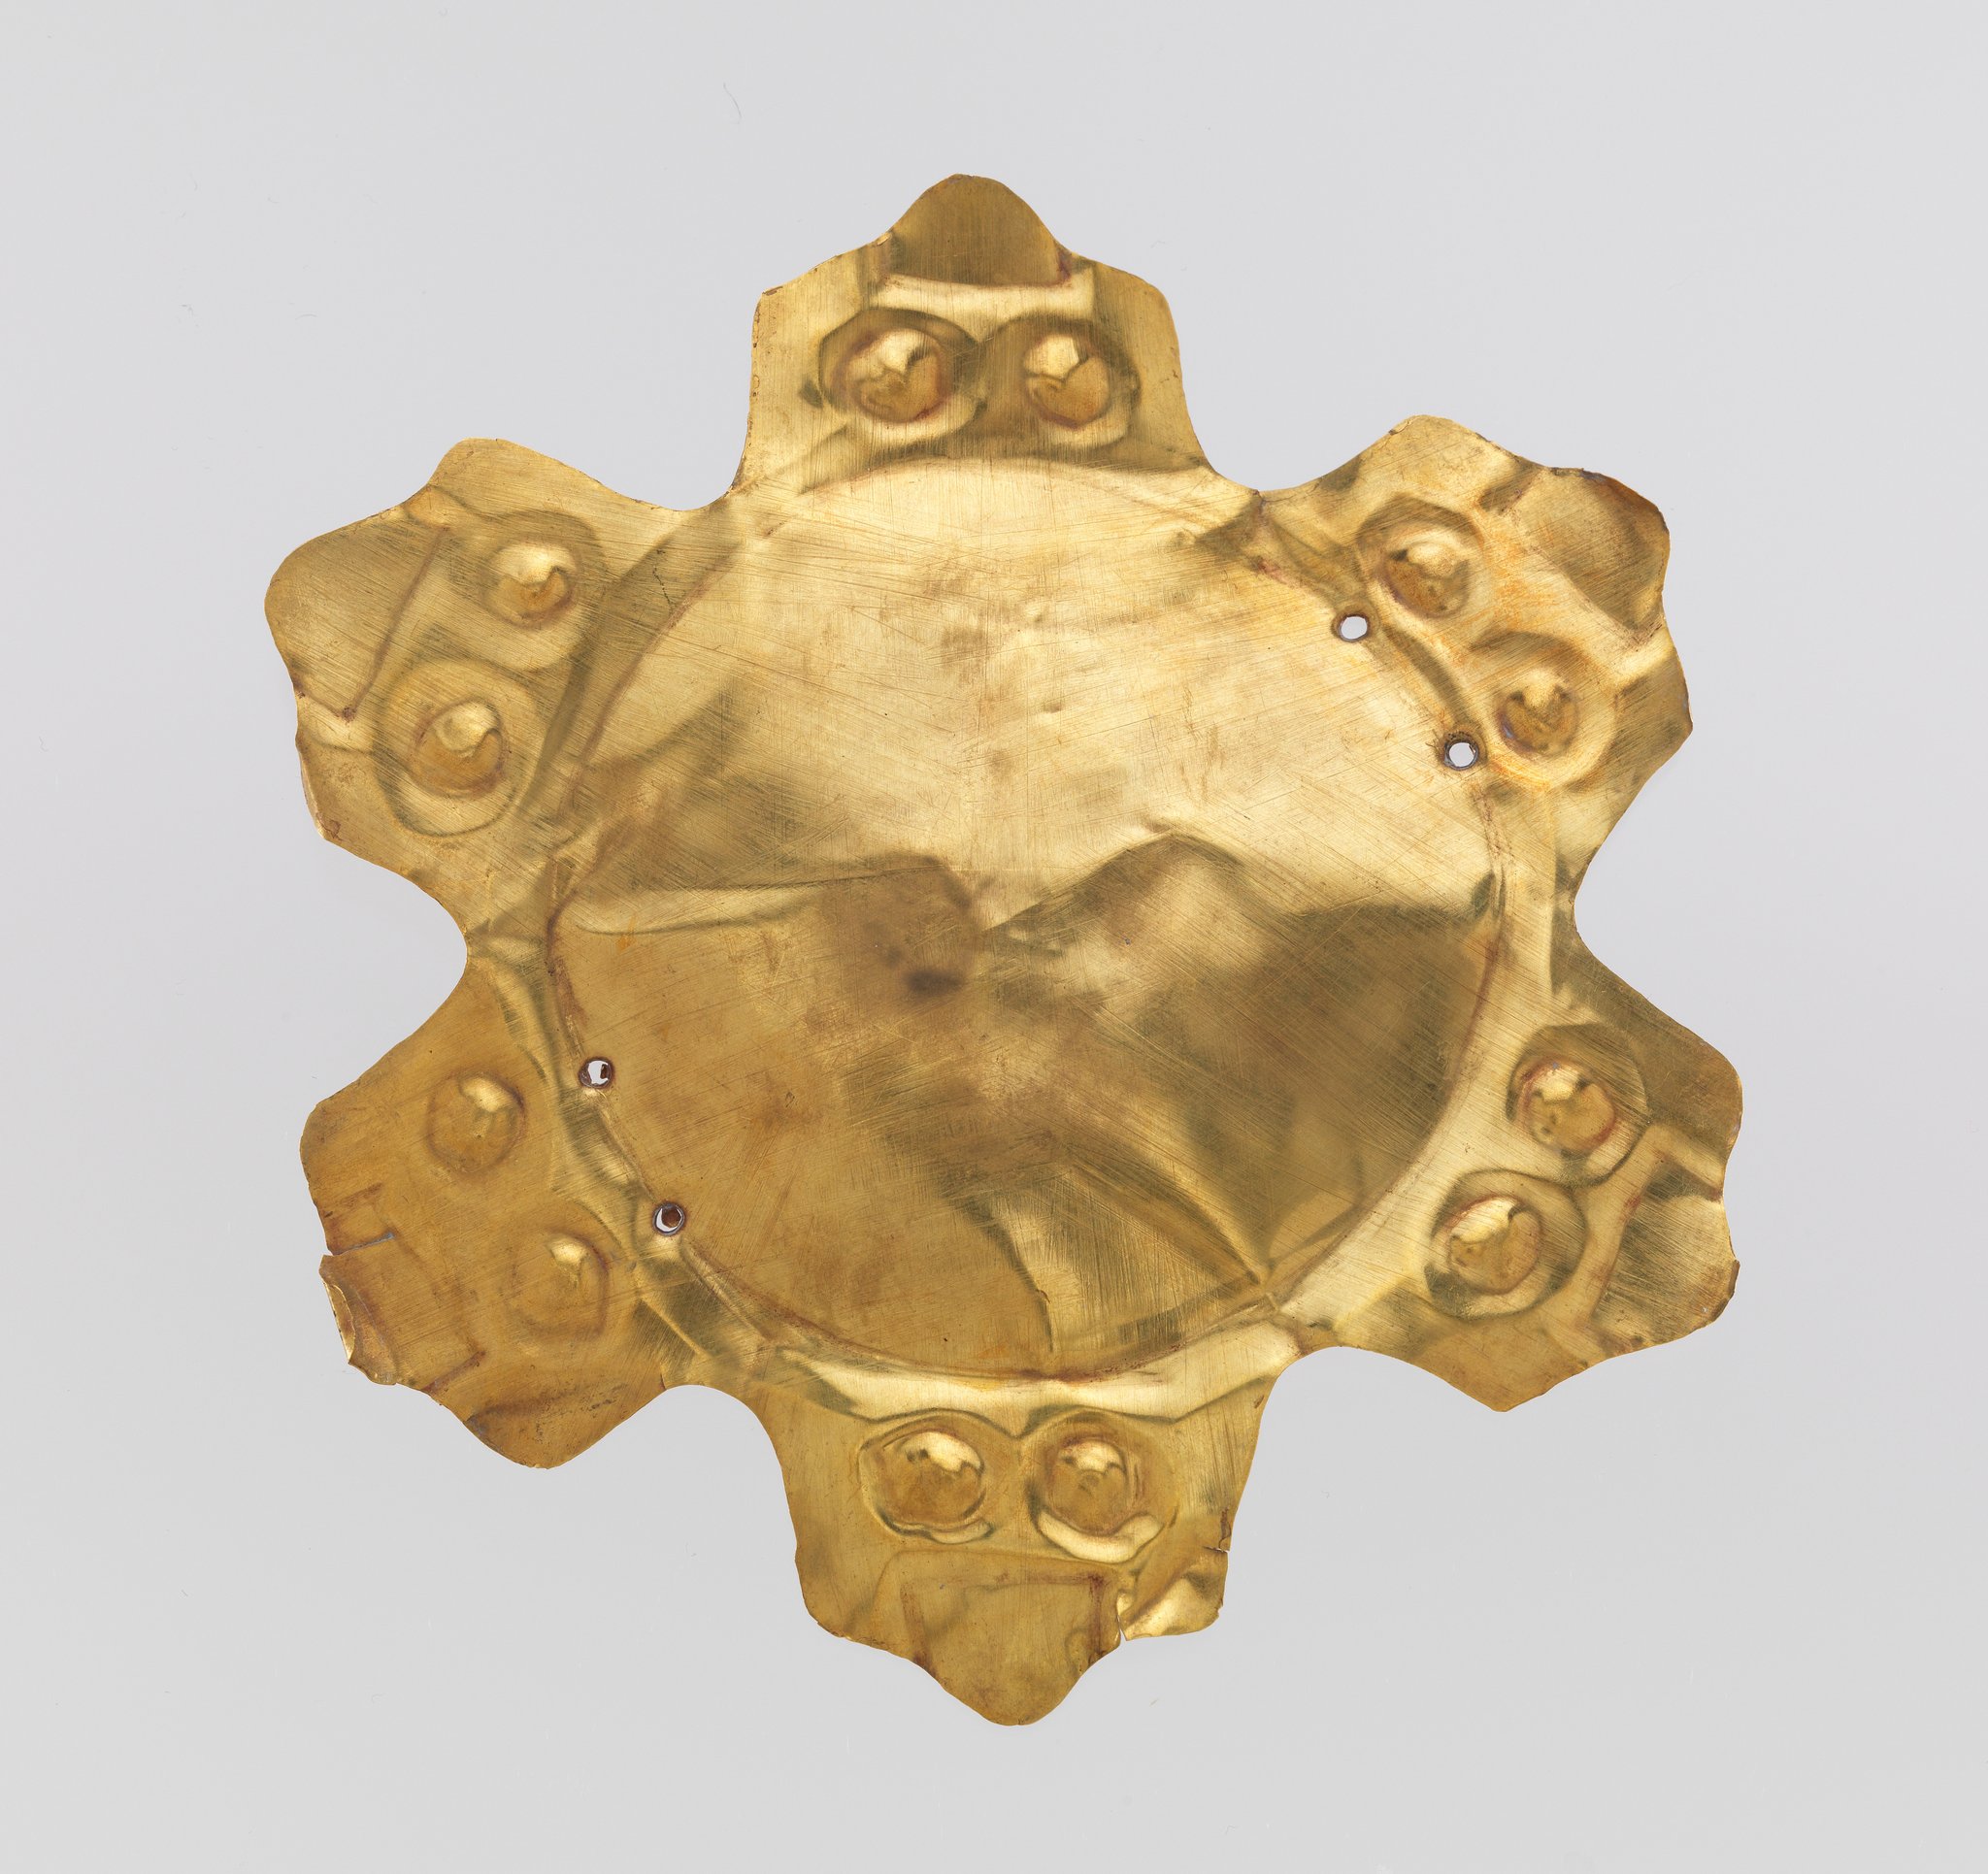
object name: ornament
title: Textile ornament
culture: nasca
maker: nasca artist(s)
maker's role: artist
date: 1-700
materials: gold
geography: peru